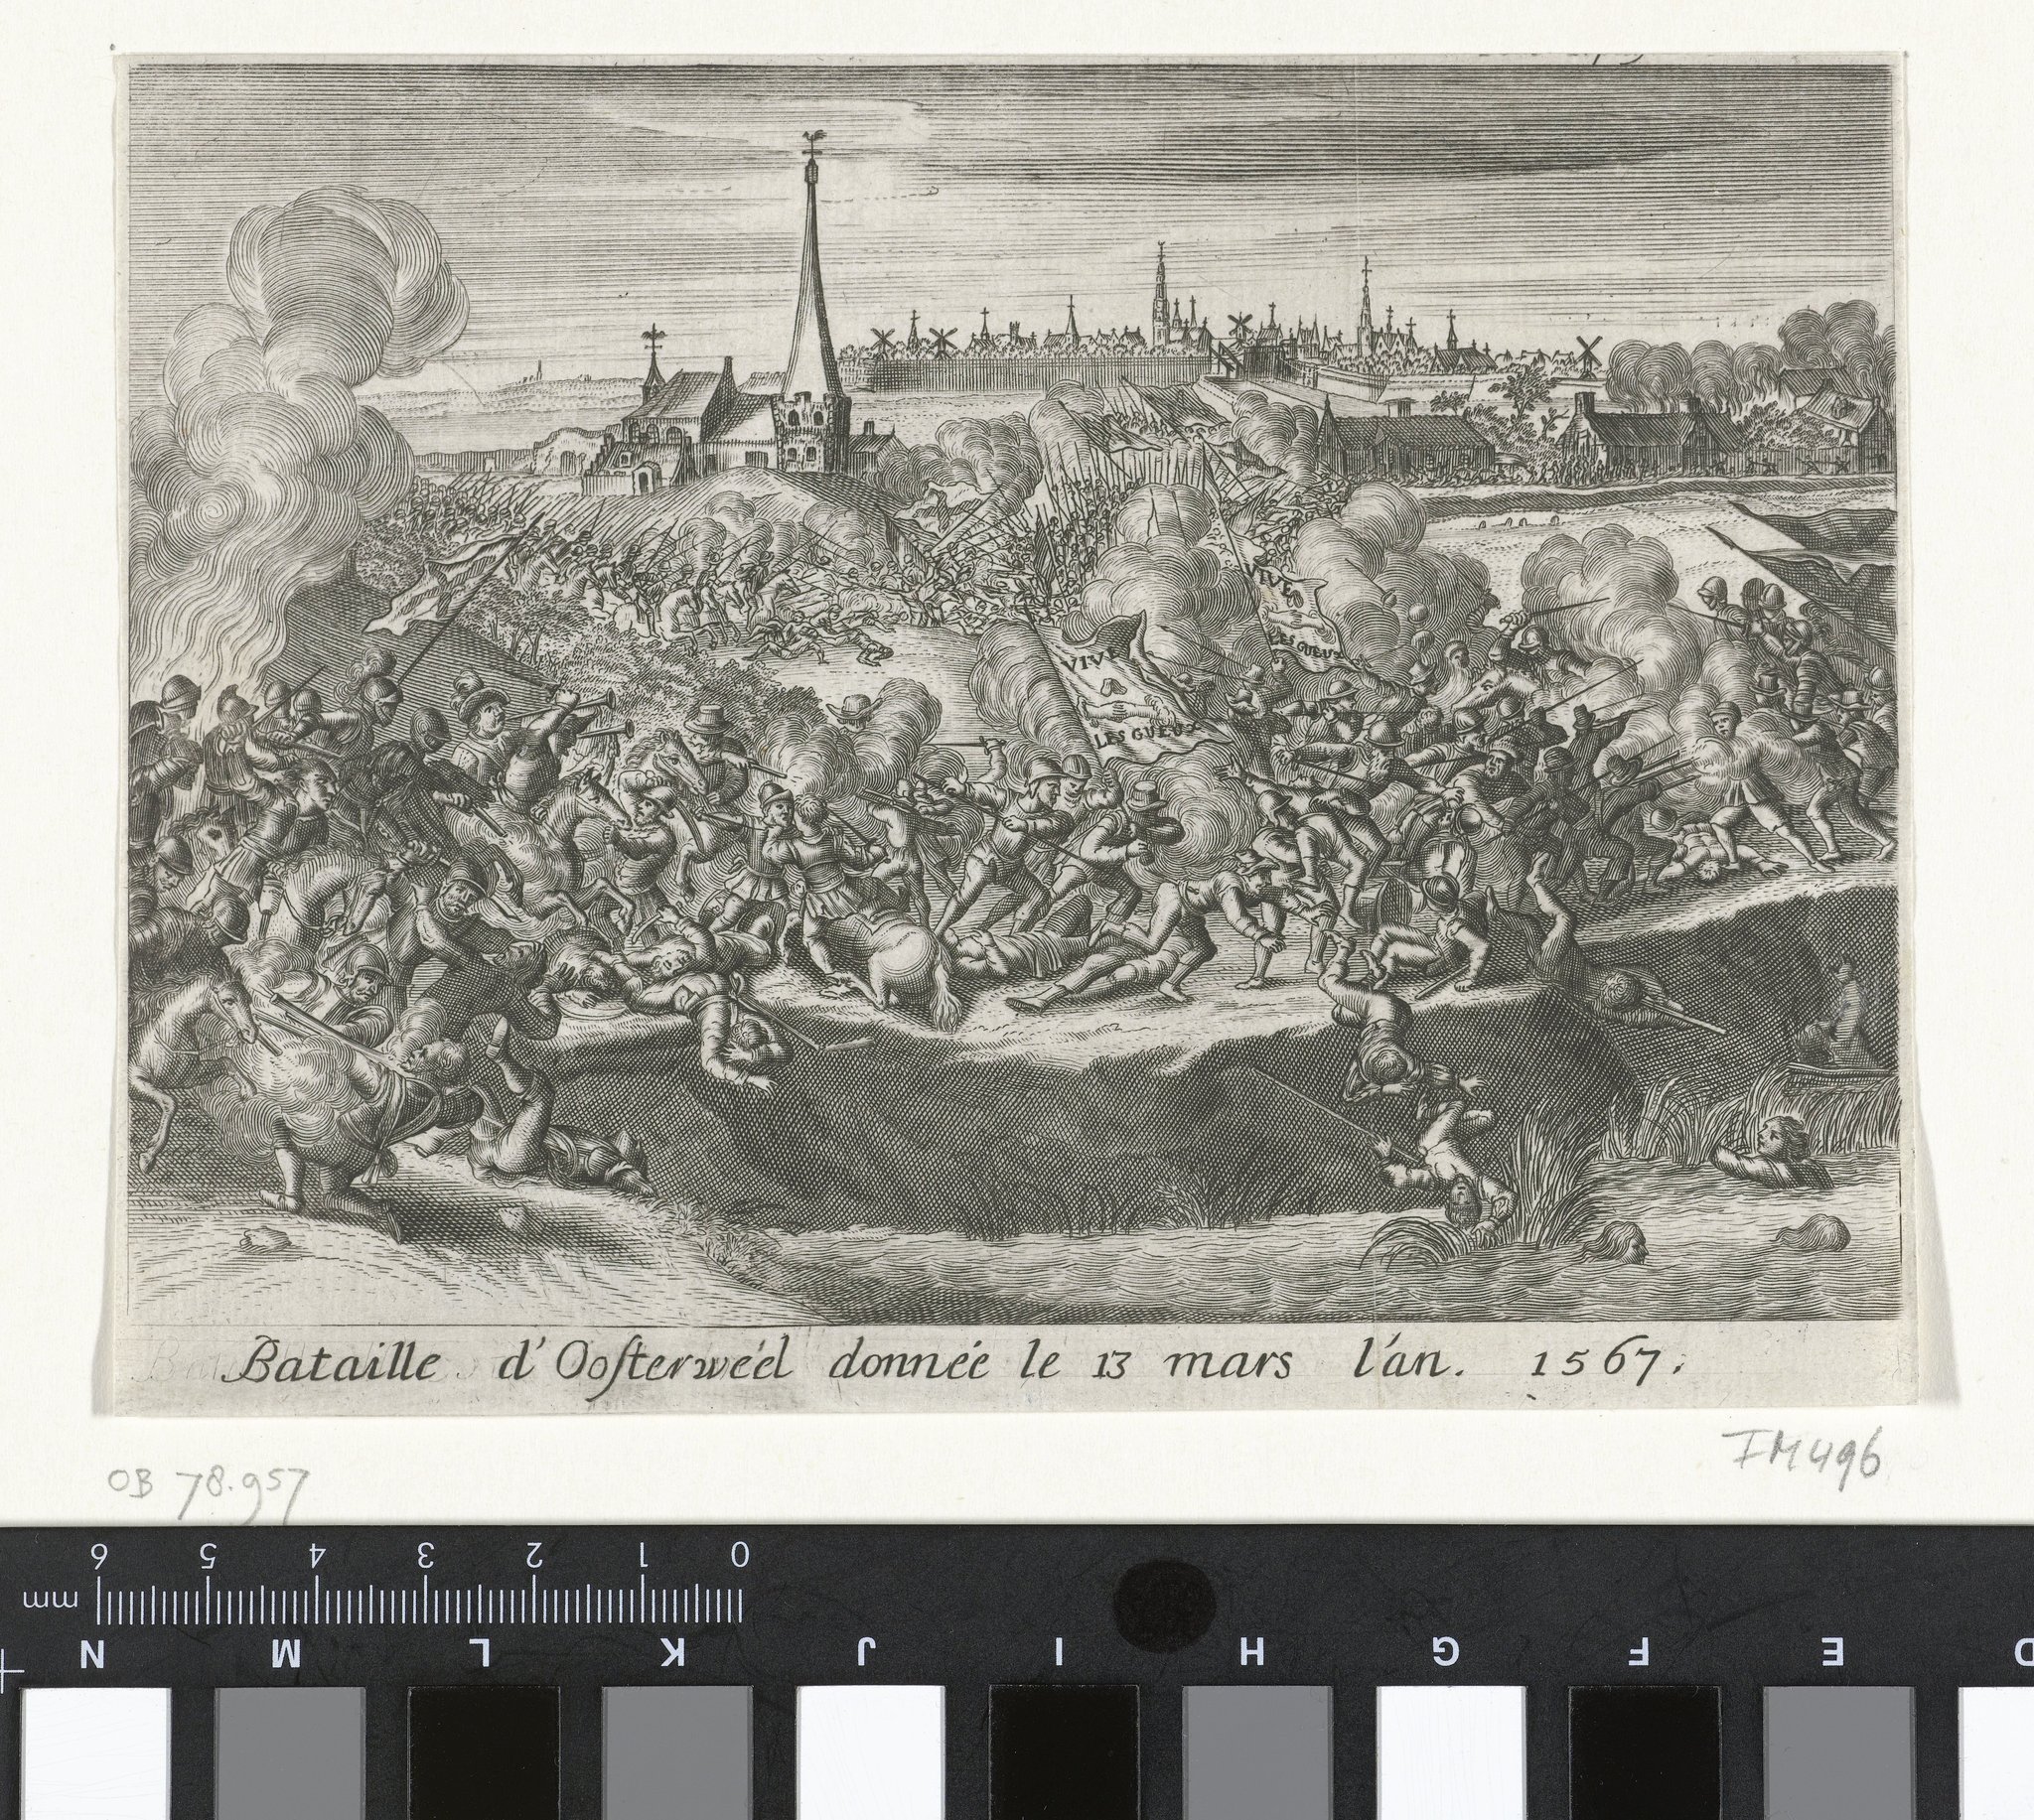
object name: history print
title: Slag bij Oosterweel, 1567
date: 1670-1699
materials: paper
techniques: engraving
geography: low countries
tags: battle, fighting in general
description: Slag bij Oosterweel, 13 maart 1567. De gevechten voor het dorpje Oosterweel buiten Antwerpen. De calvinisten onder leiding van Jan van Marnix worden verslagen door de troepen van de hertog van Aremberg en Philips van Lanoy. Met onderschrift van 1 regel in het Frans.